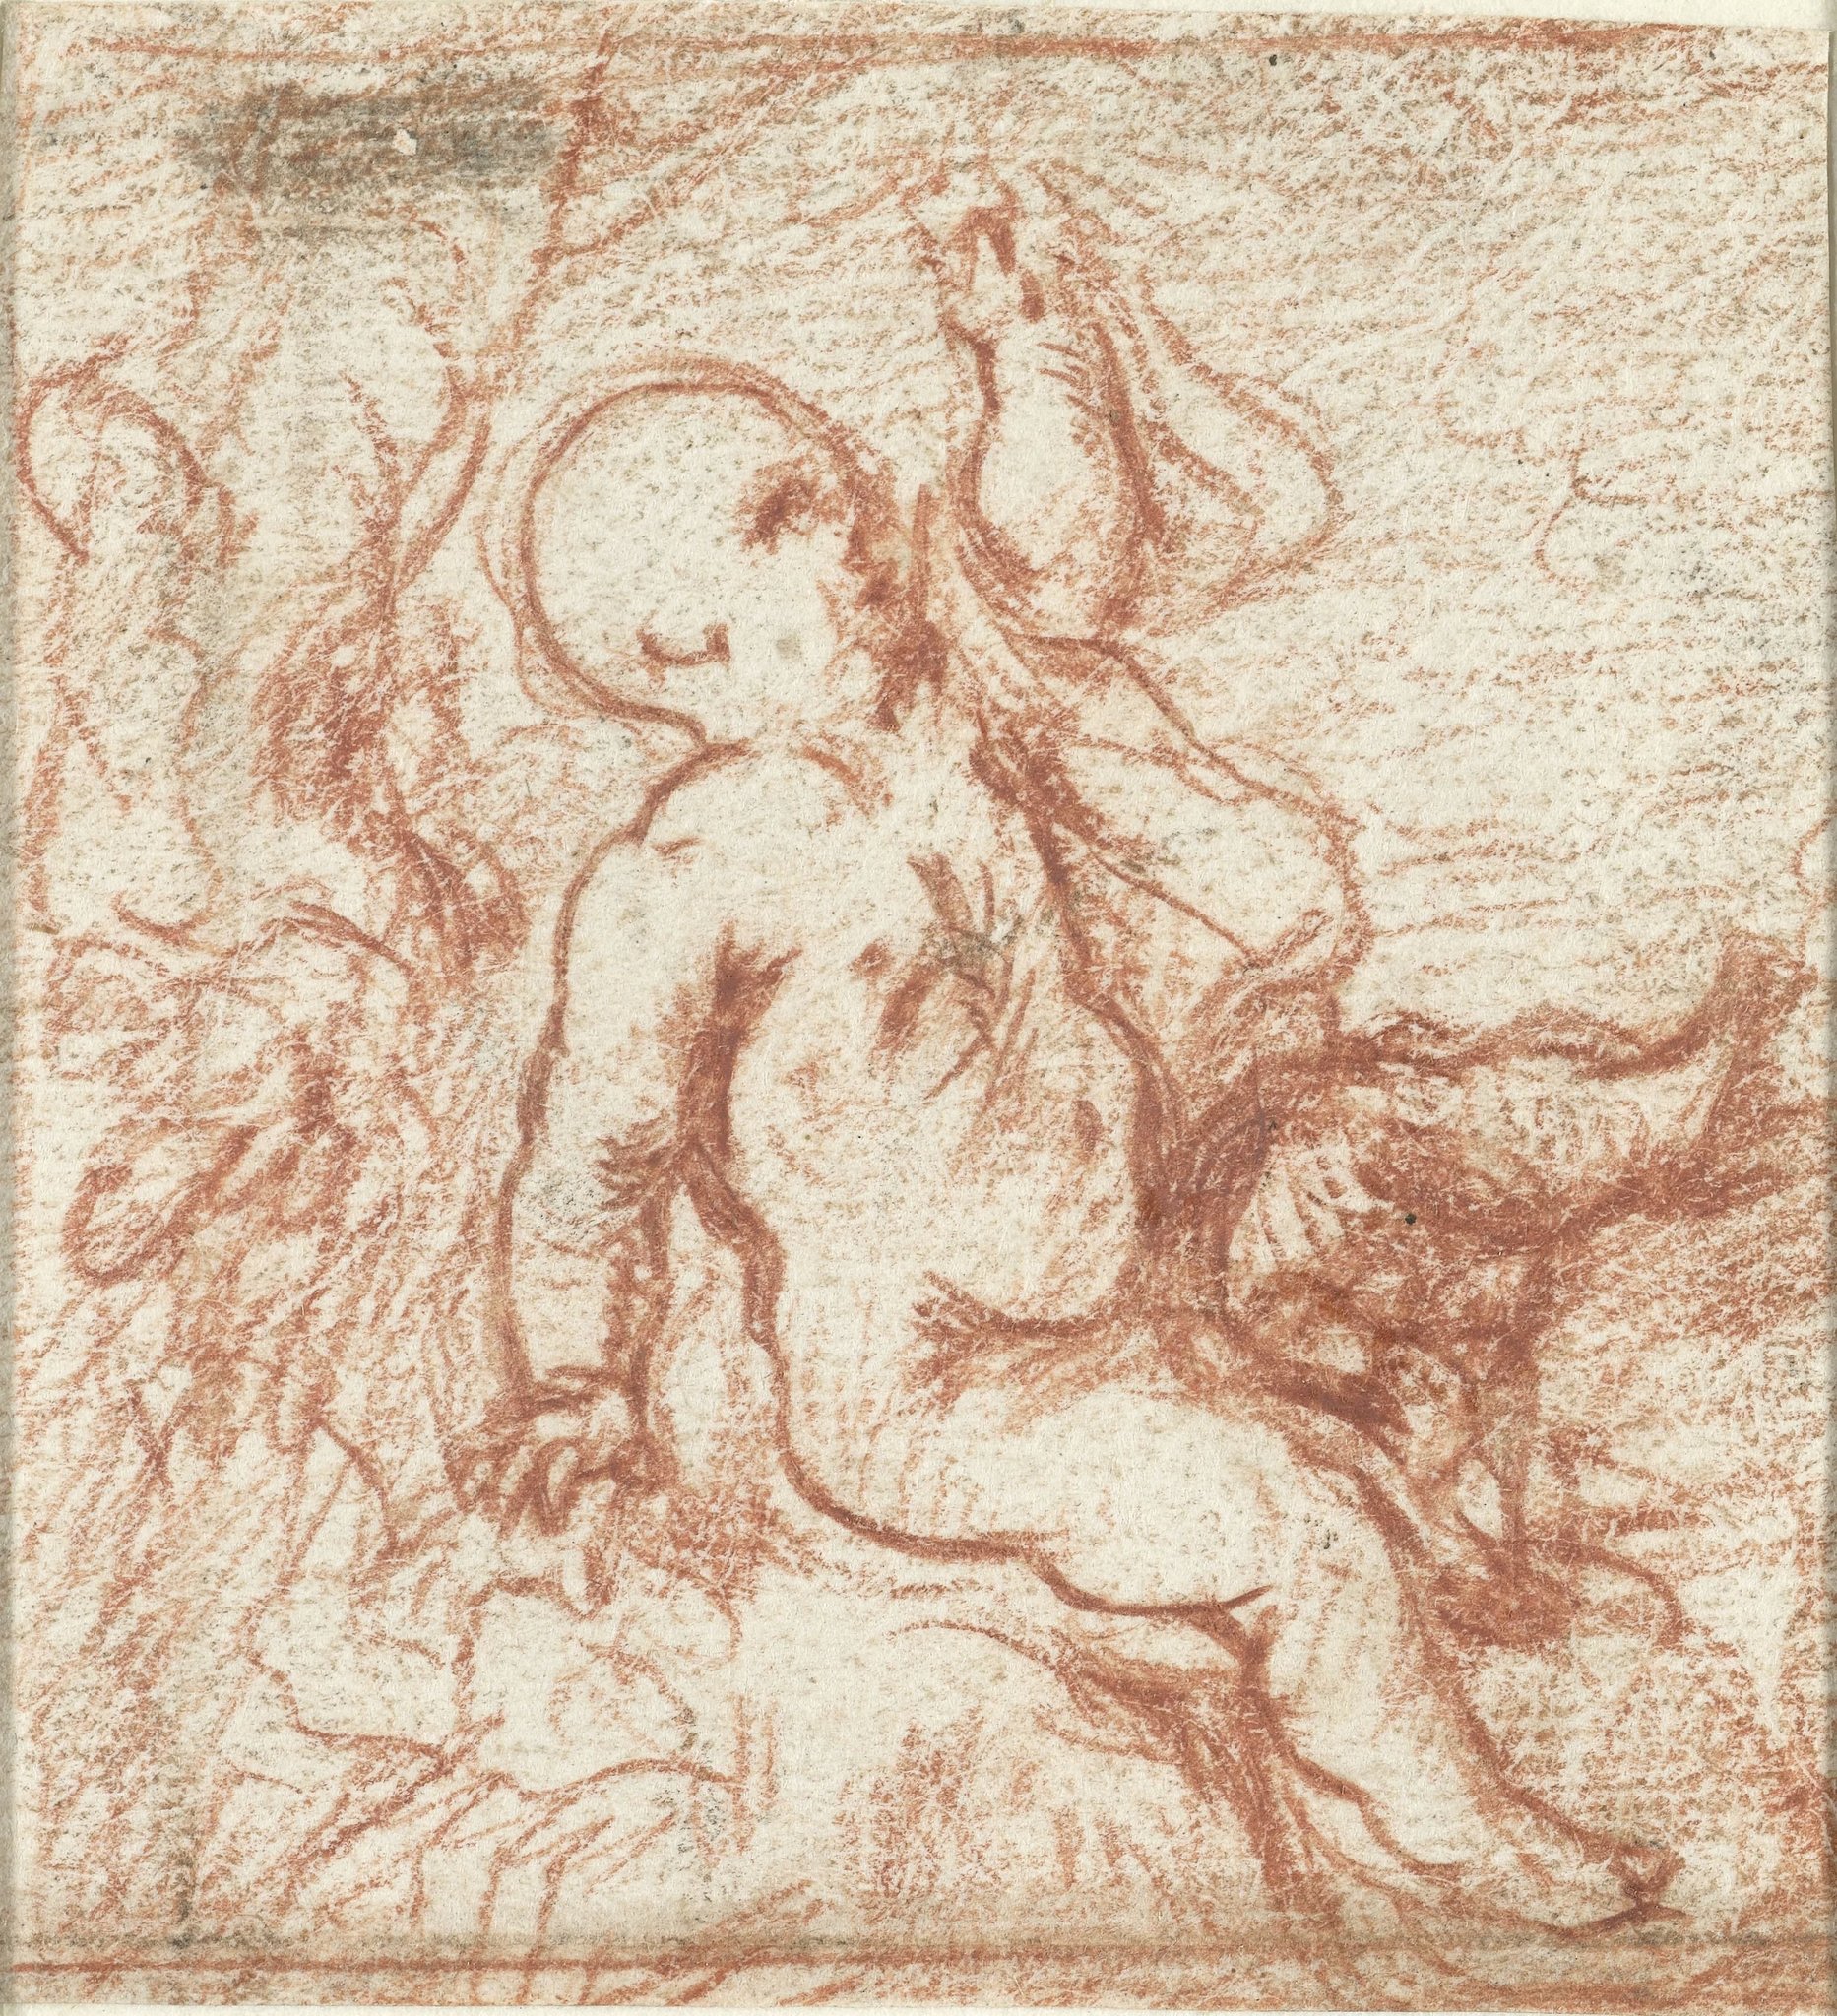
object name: drawing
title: Putto in landschap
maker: Anonymous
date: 1700-1800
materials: chalk, paper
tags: infant, baby ~ the ages of man, cupids: 'amores', 'amoretti', 'putti'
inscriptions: collector's mark, verso, lower centre: Lugt 2228